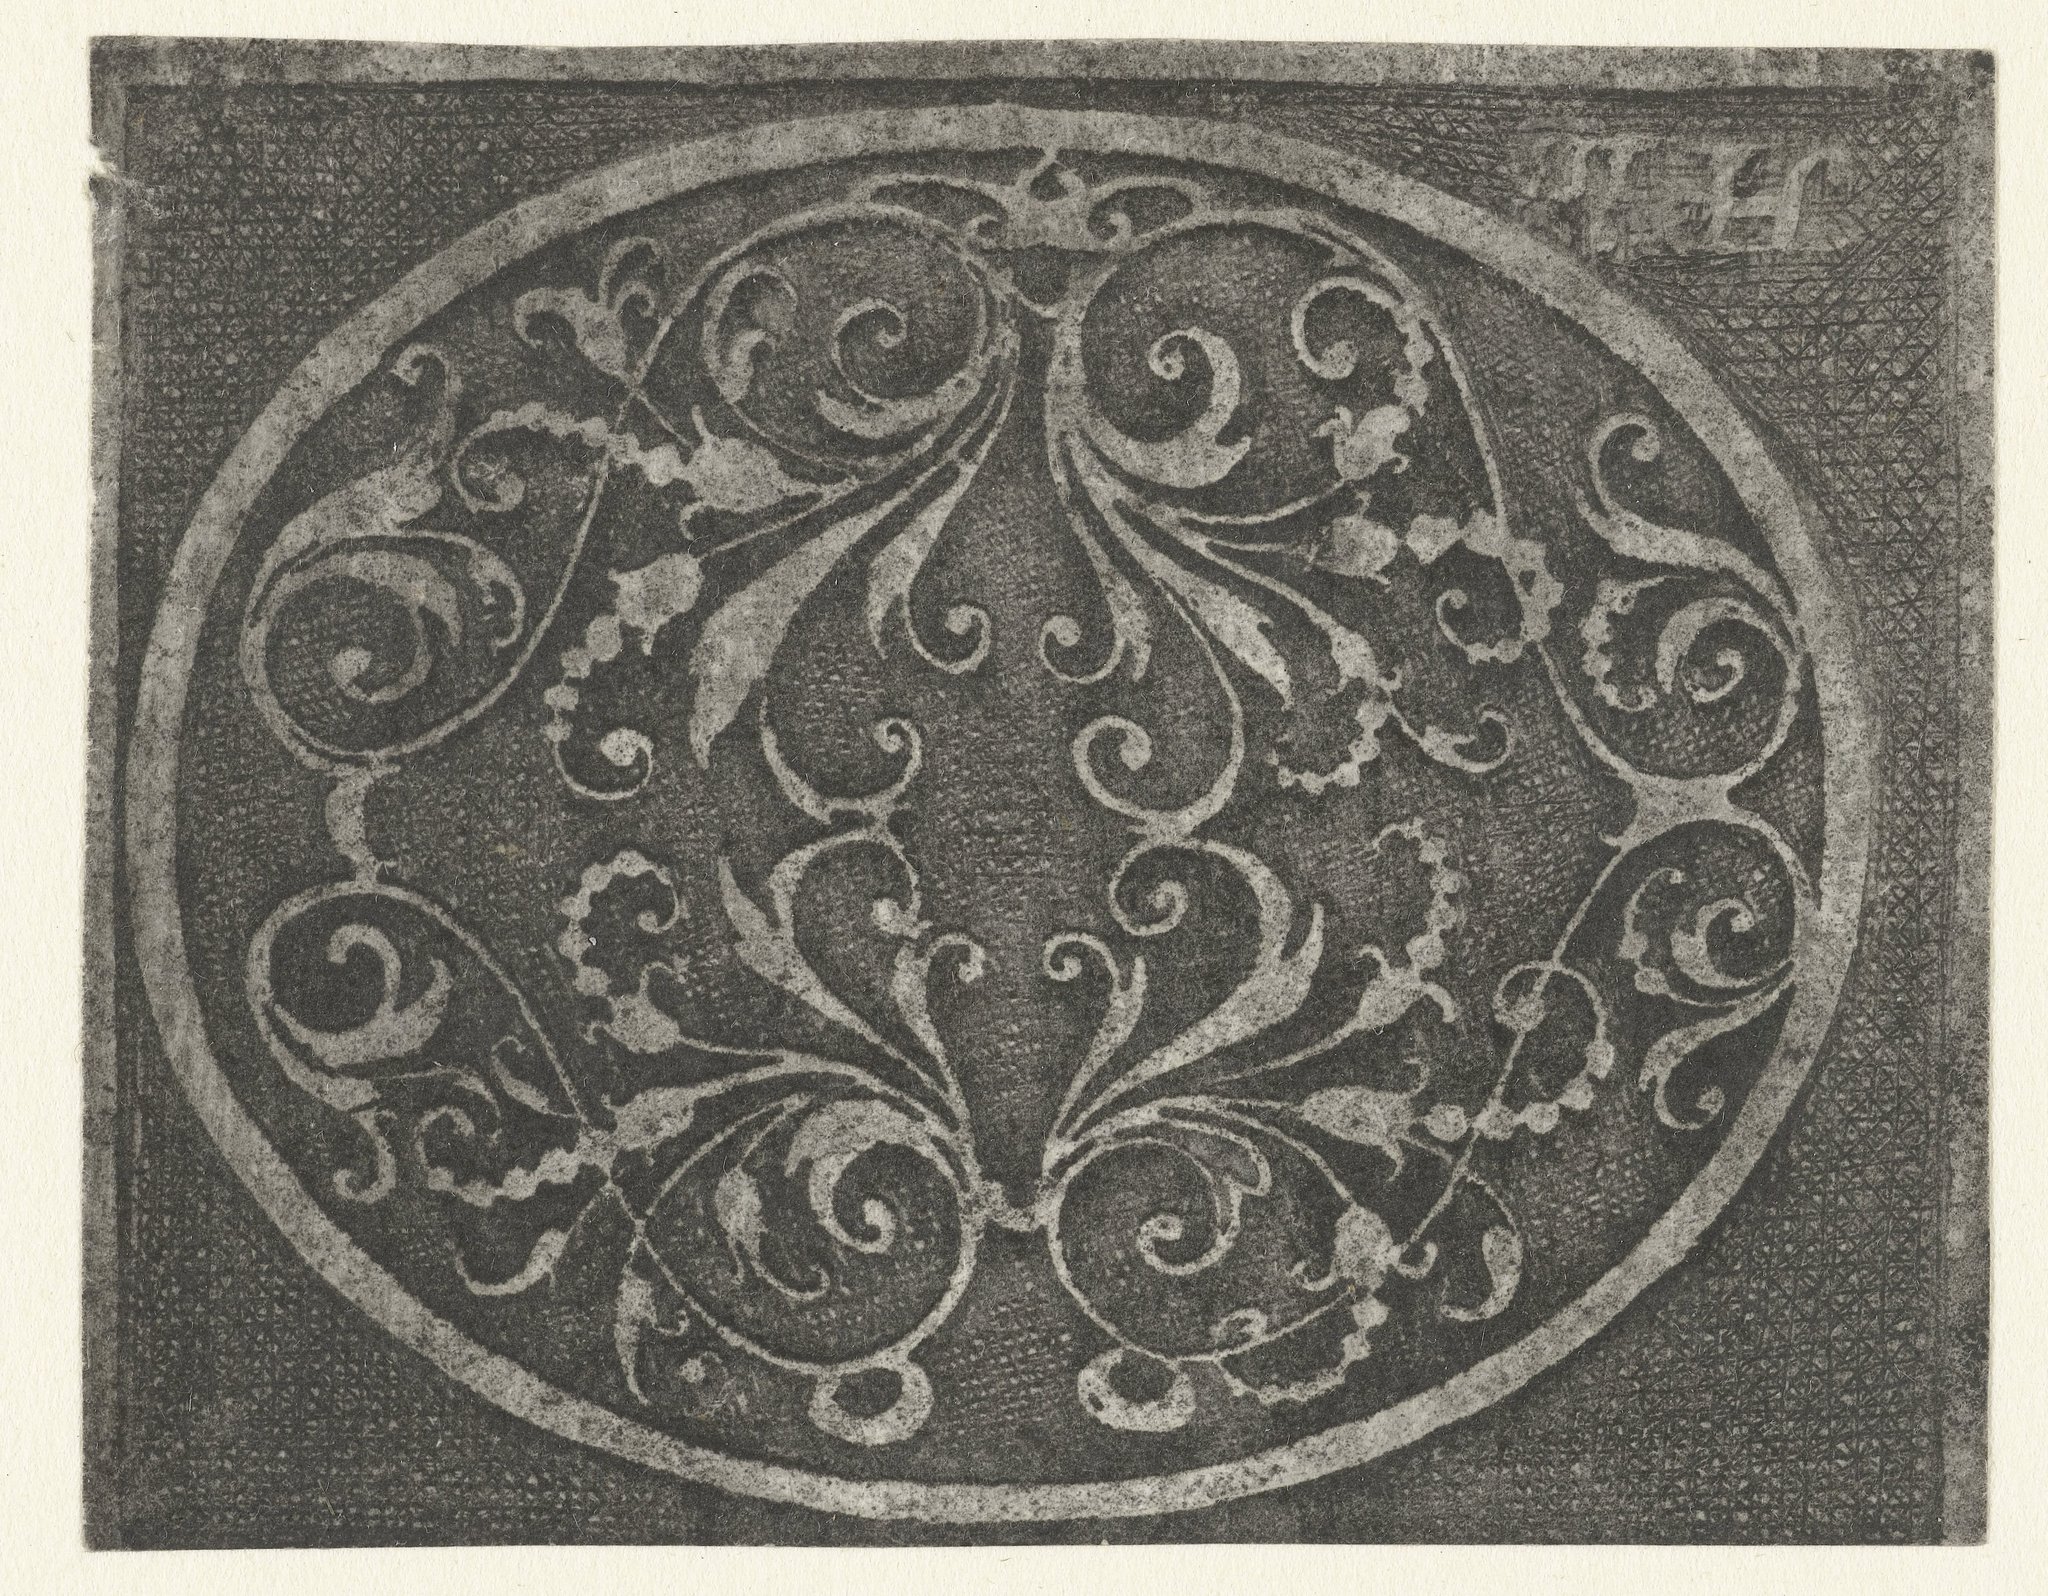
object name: ornament print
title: Livre de Diverses Ordonnances de Fevillages Moresqves, Crotesqves Rabesqves et Avtres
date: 1638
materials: paper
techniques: engraving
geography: france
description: Decoratie voor affuit. Uit serie van titelblad en 21 bladen.